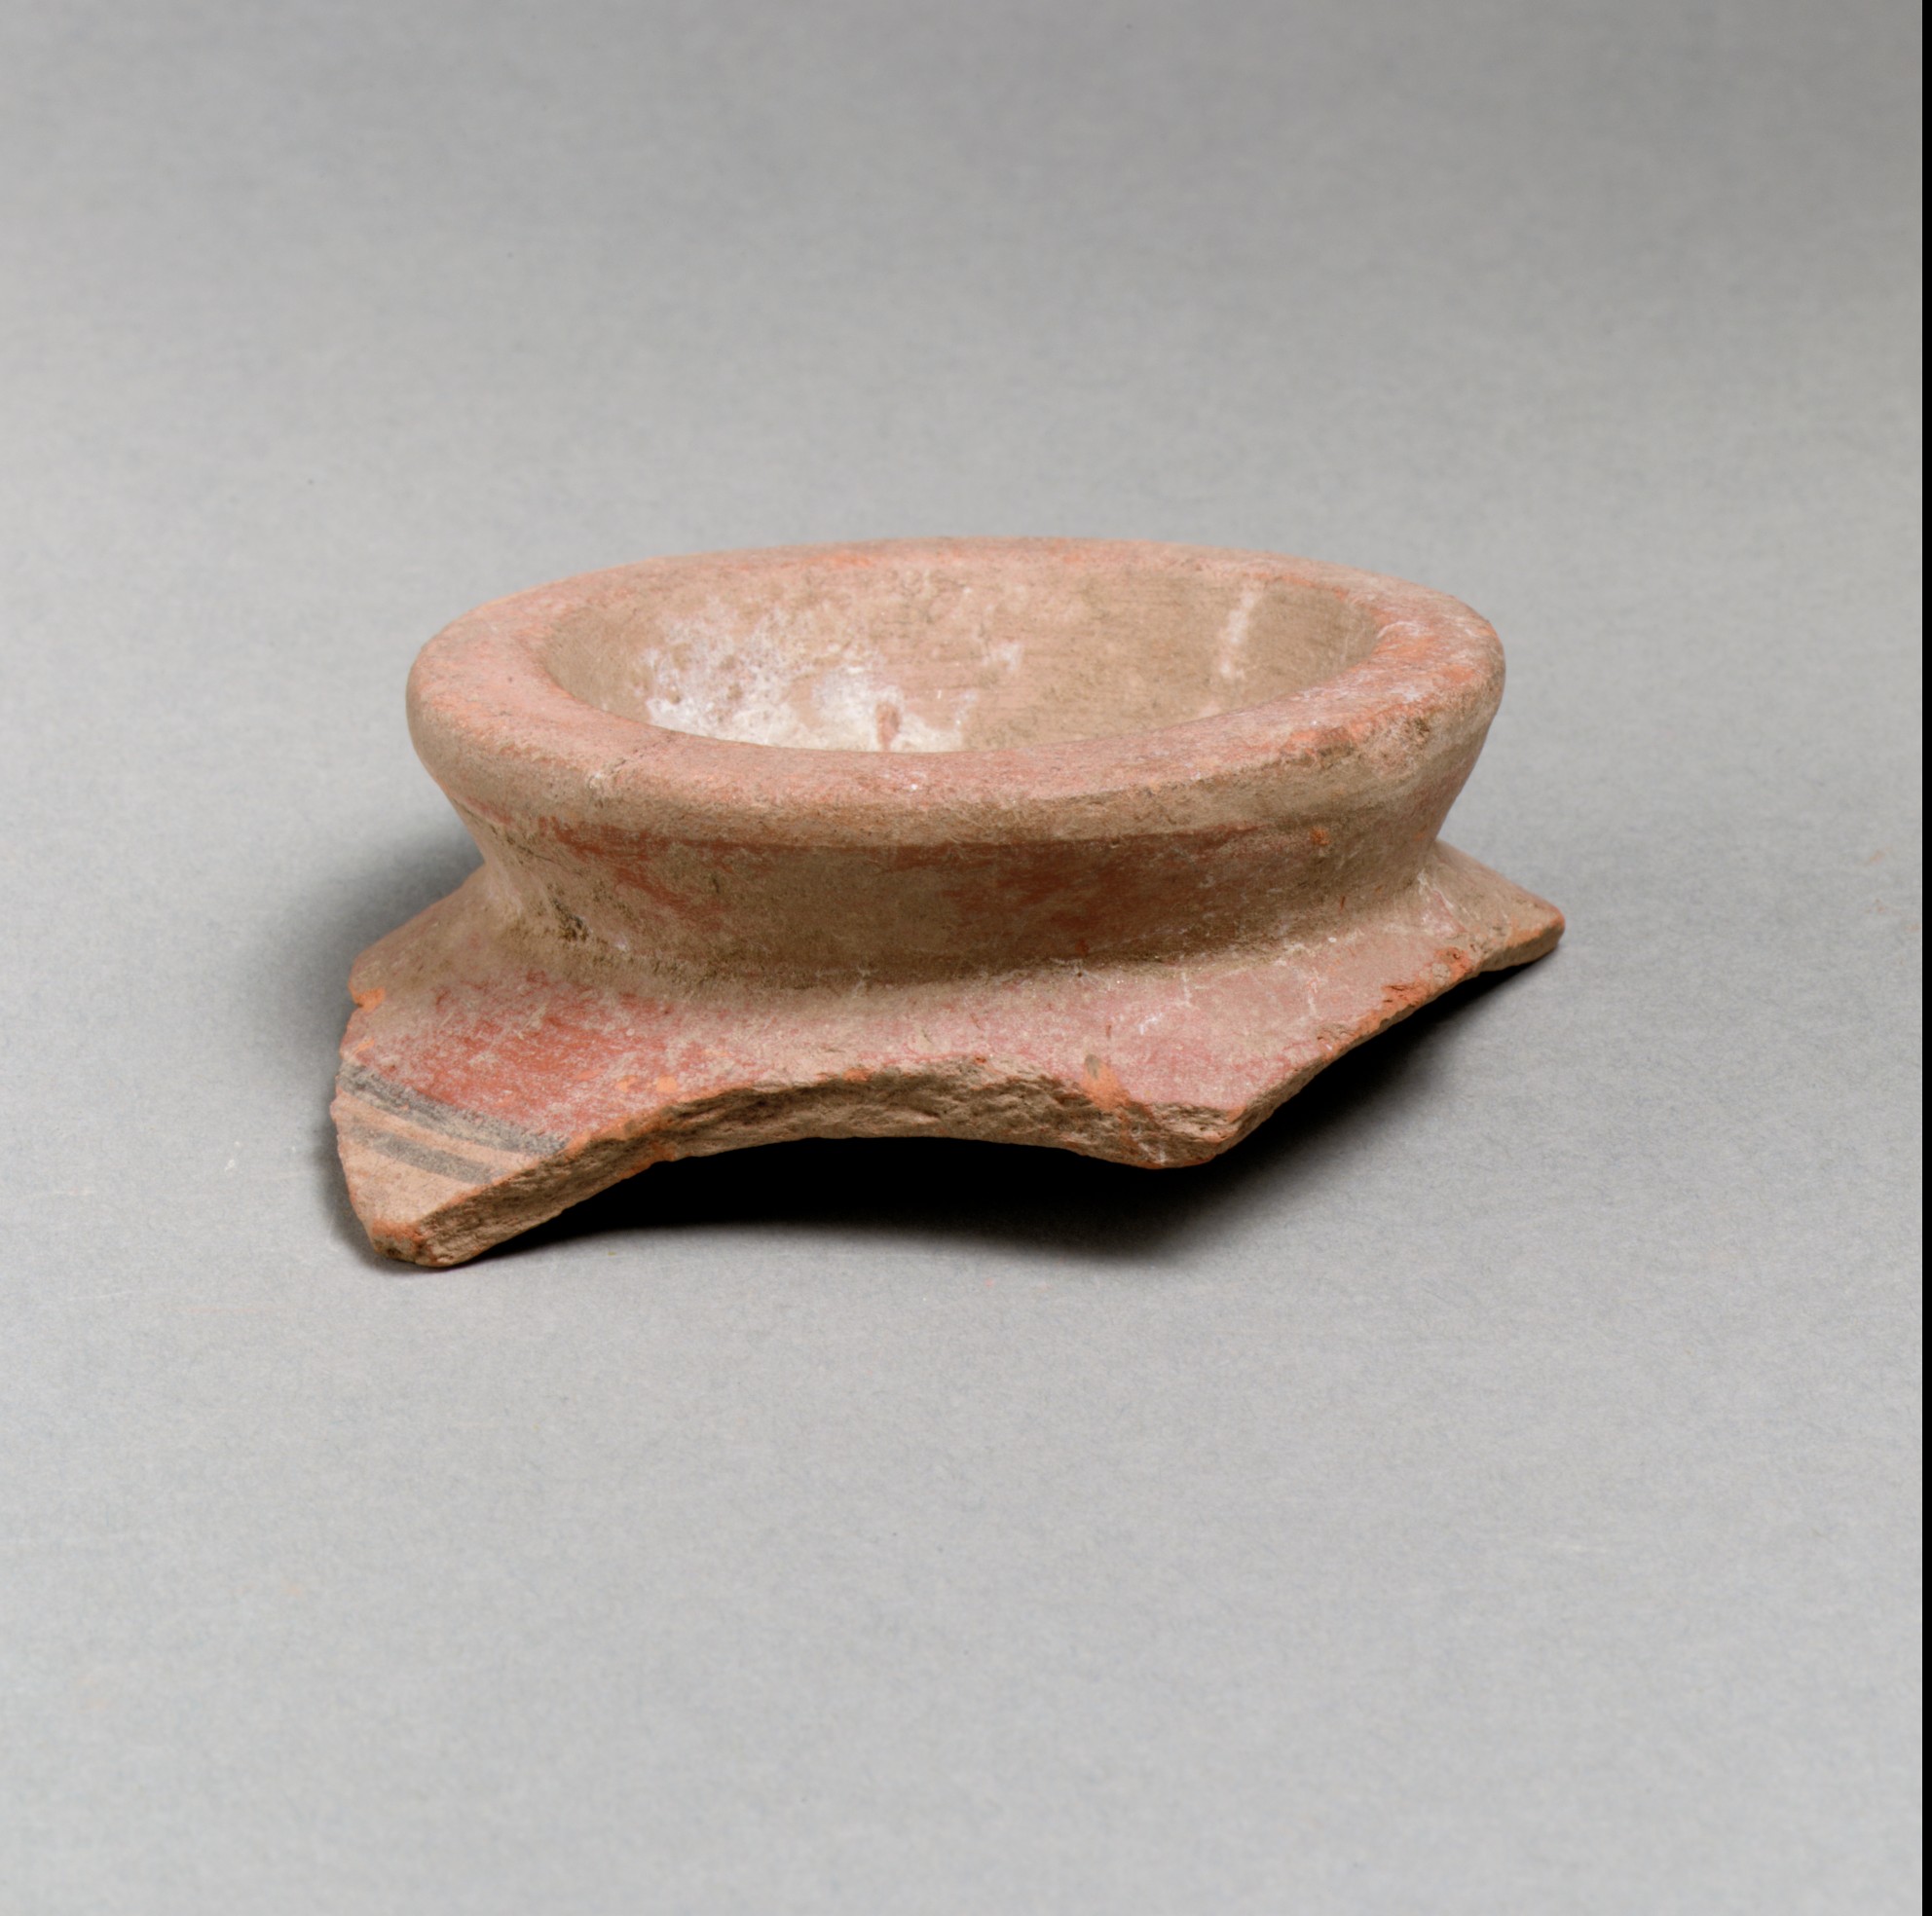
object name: vase fragment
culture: greek or lydian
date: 800-480 BCE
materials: terracotta